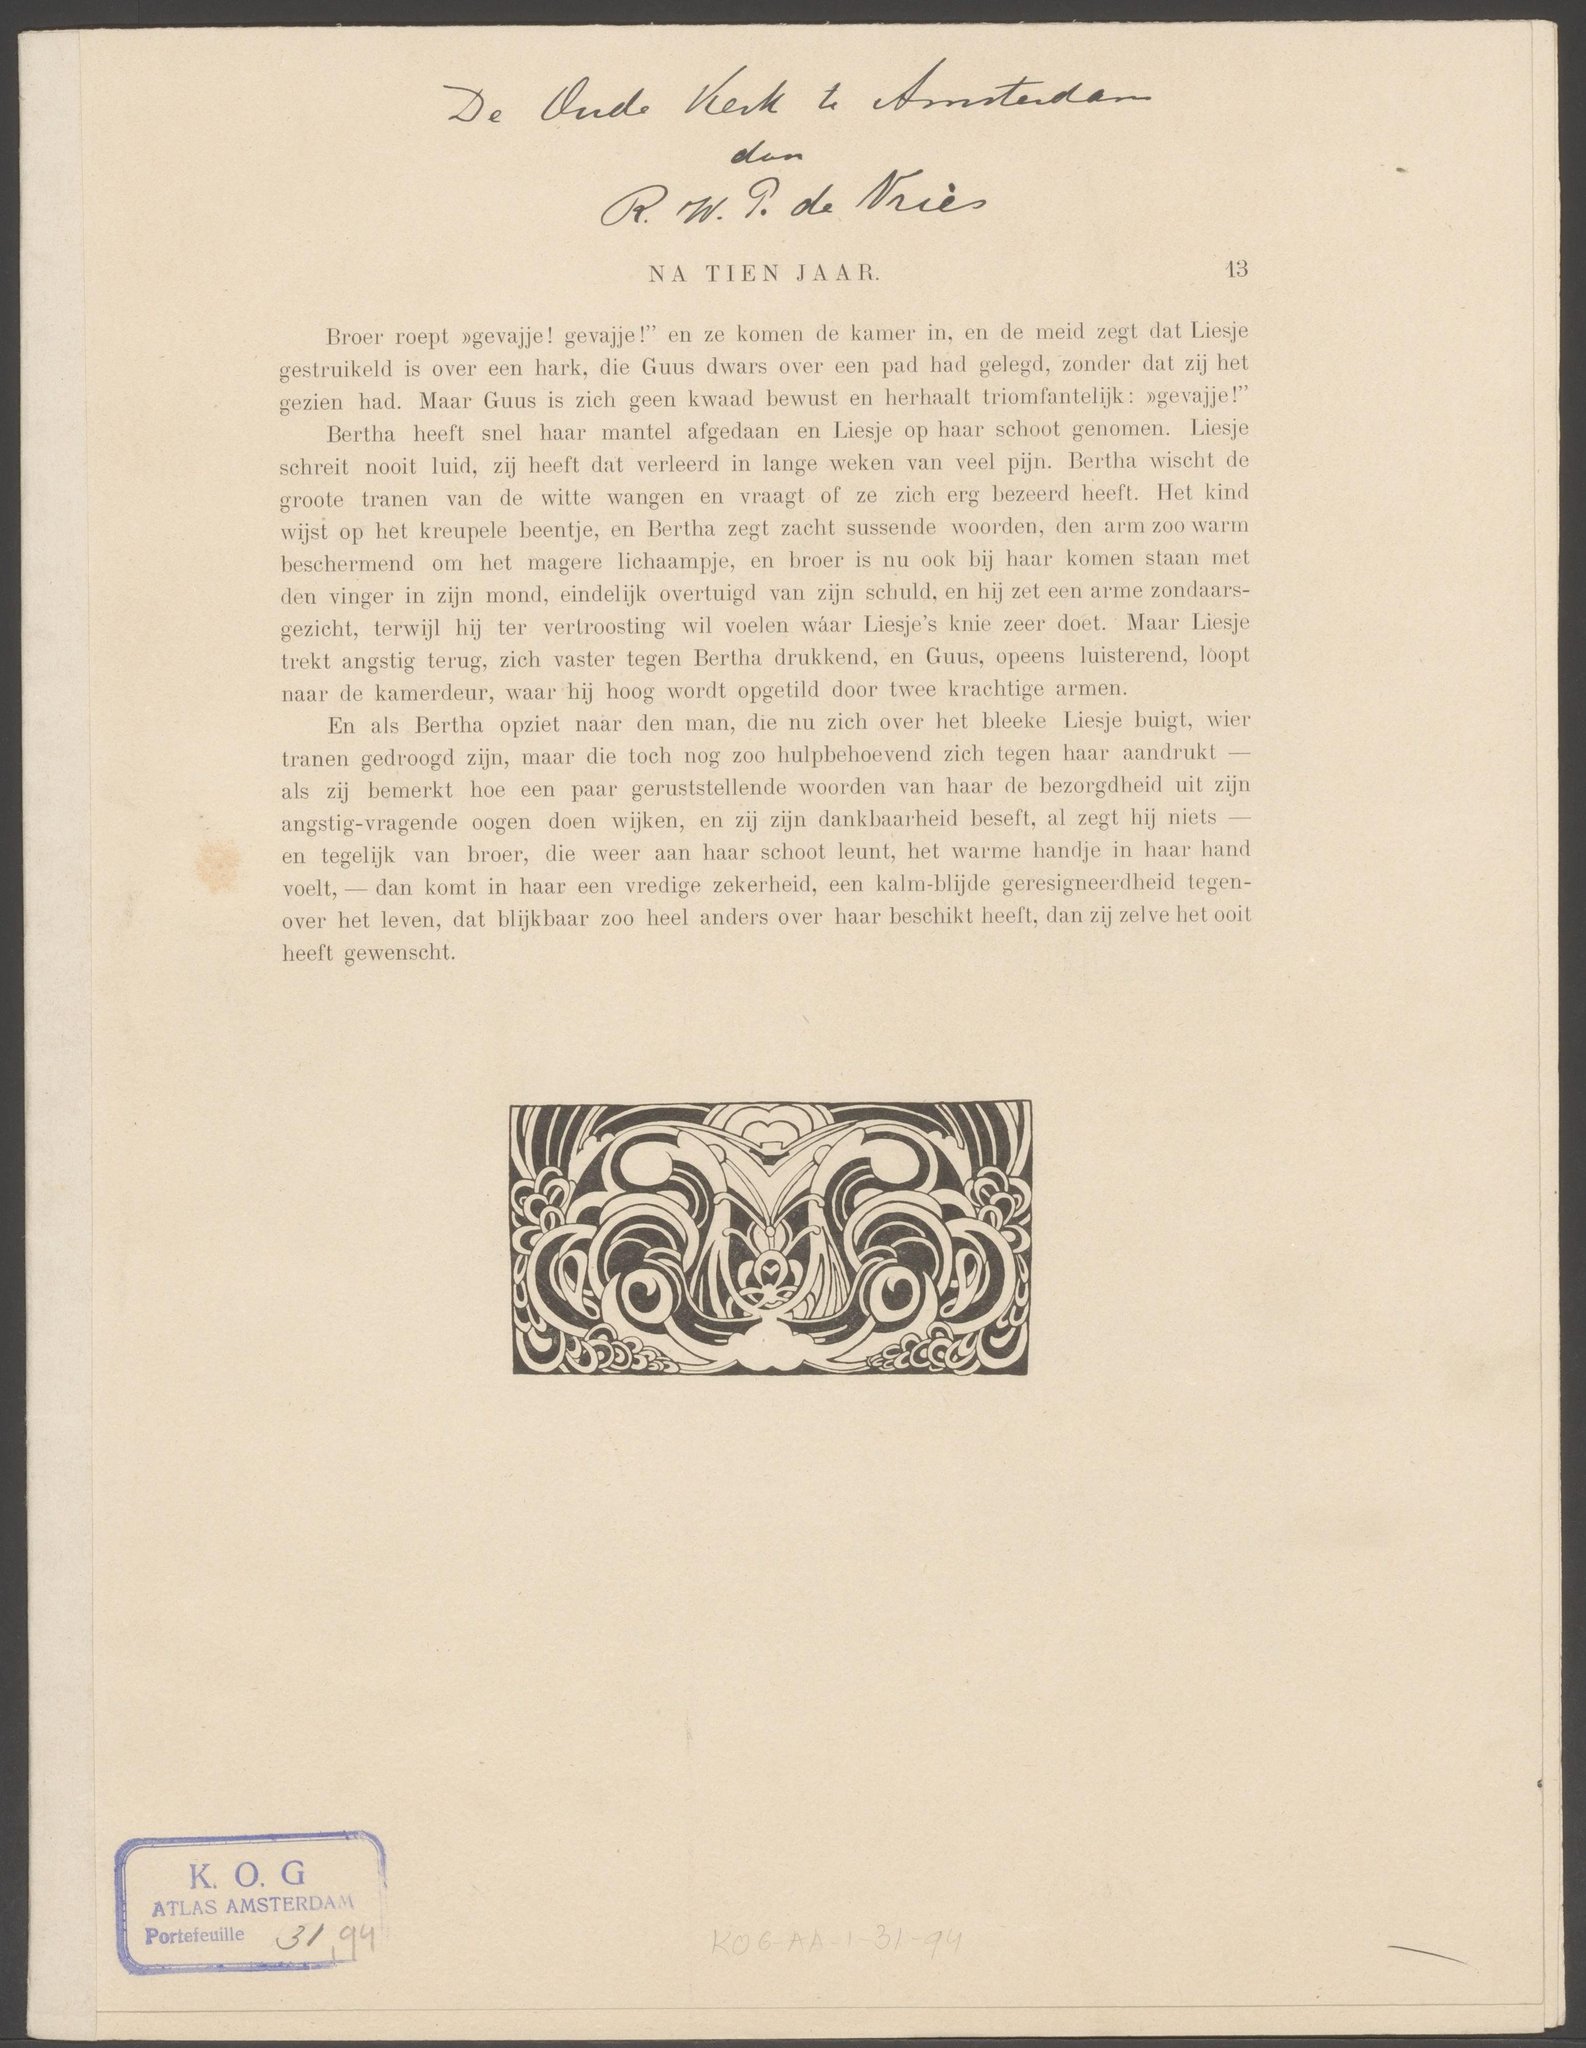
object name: article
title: Artikel over de Oude Kerk te Amsterdam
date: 1899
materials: paper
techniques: letterpress printing, line block, engraving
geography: haarlem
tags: architectural detail, interior of church, parts of church exterior and annexes, epitaph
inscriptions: collector's mark: ‘31.94’ Lugt 1641b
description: Artikel uit Woord en Beeld; Geïllustreerd maandschrift (1899), bestaande uit tien pagina's met zeventien illustraties. Onderwerpsrubriek binnen de Atlas Amsterdam: Kerkwezen: Hervormde Gemeente: Oude Kerk van buiten.